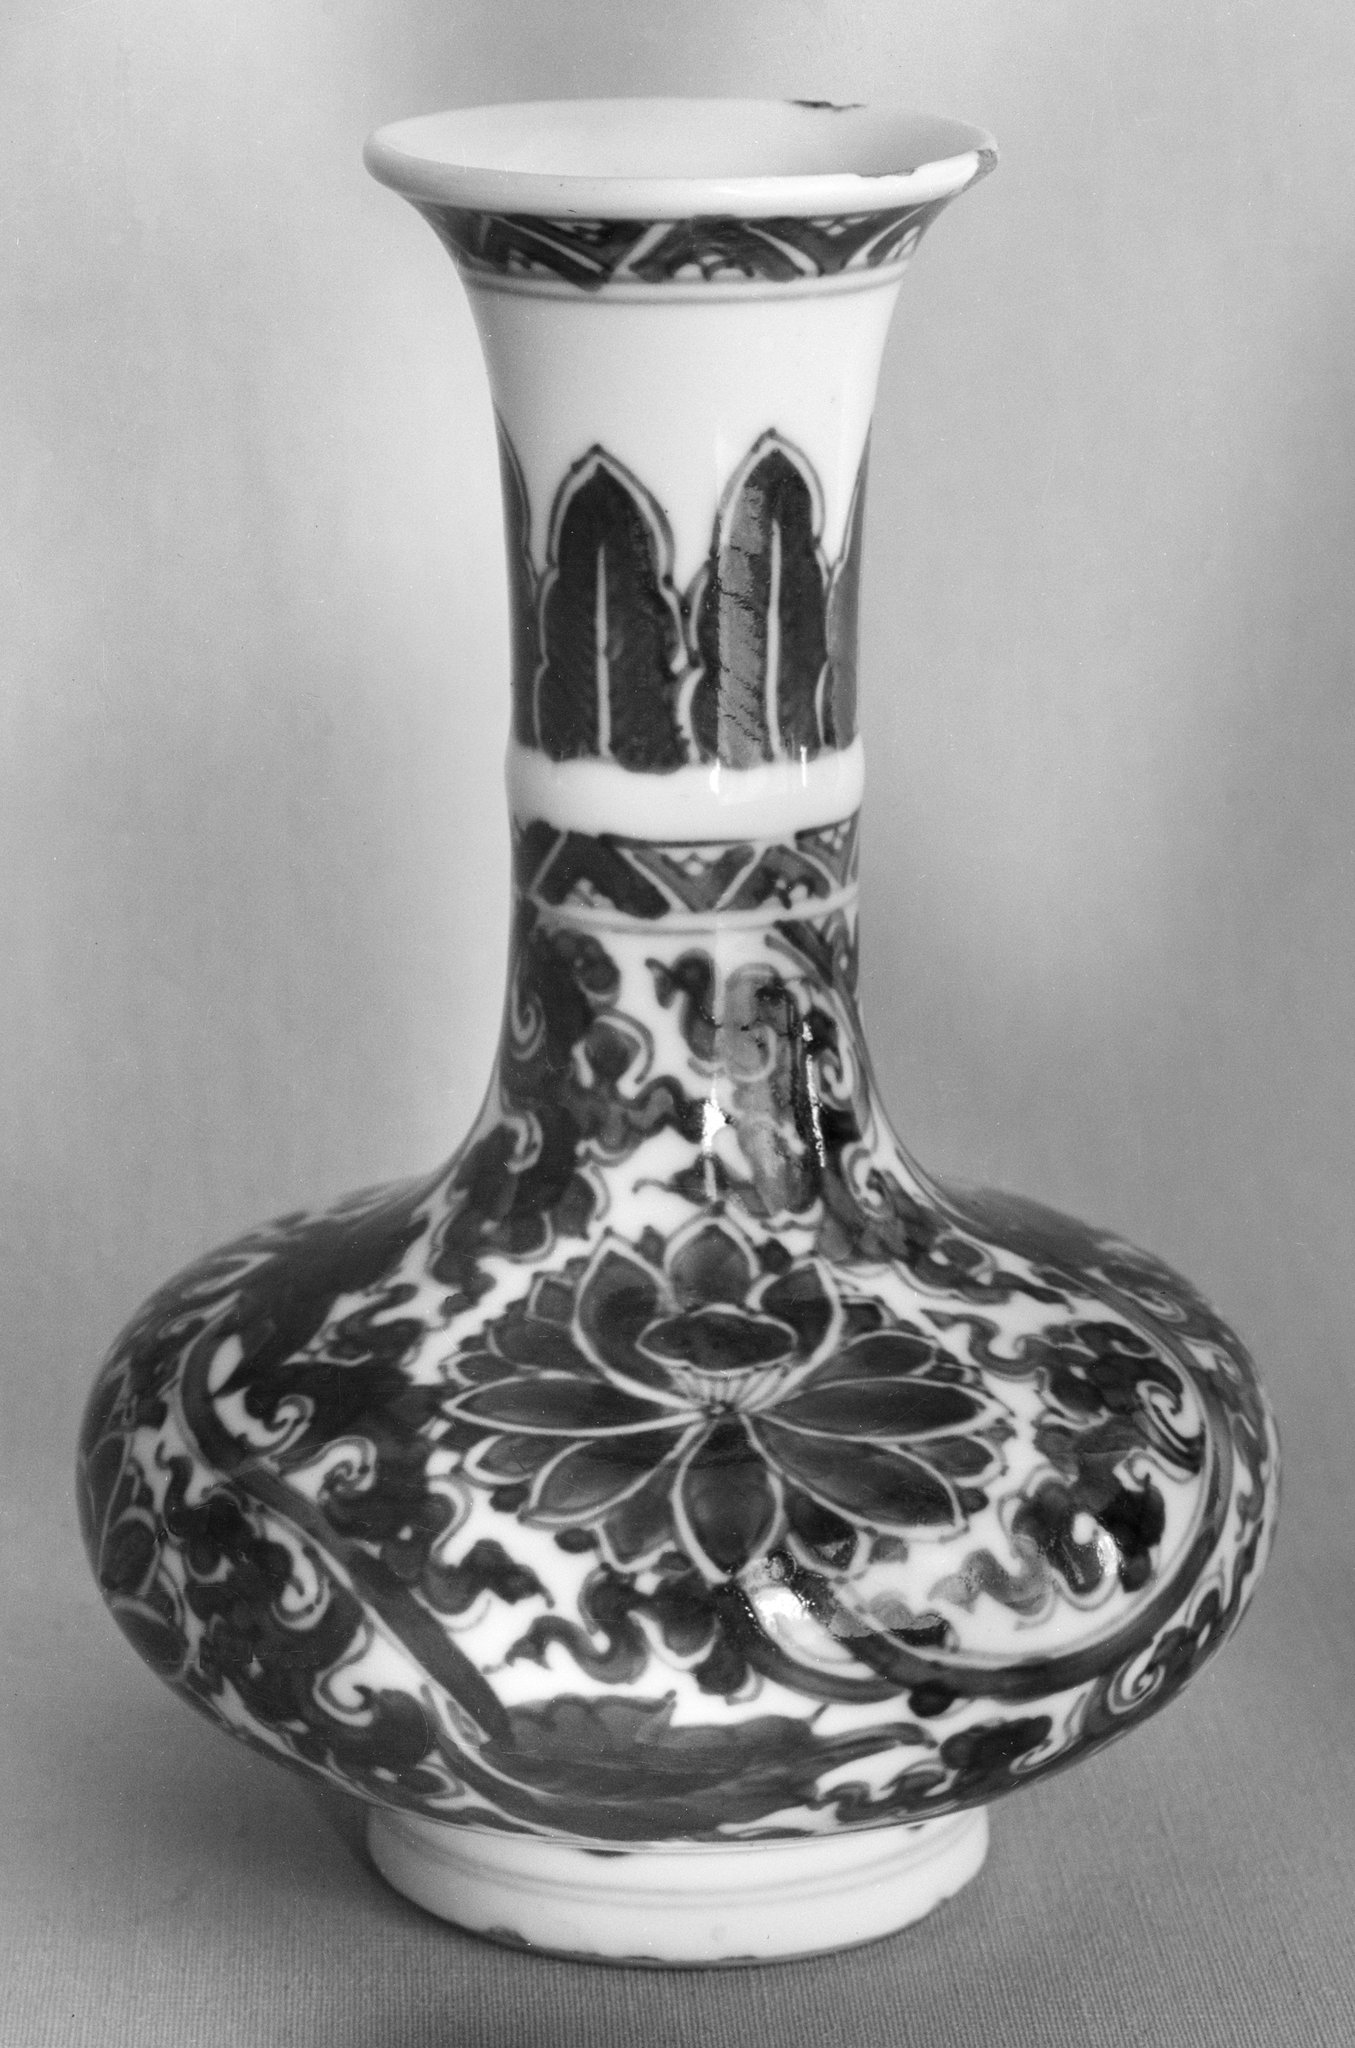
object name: bottle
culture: chinese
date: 1662-1722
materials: porcelain